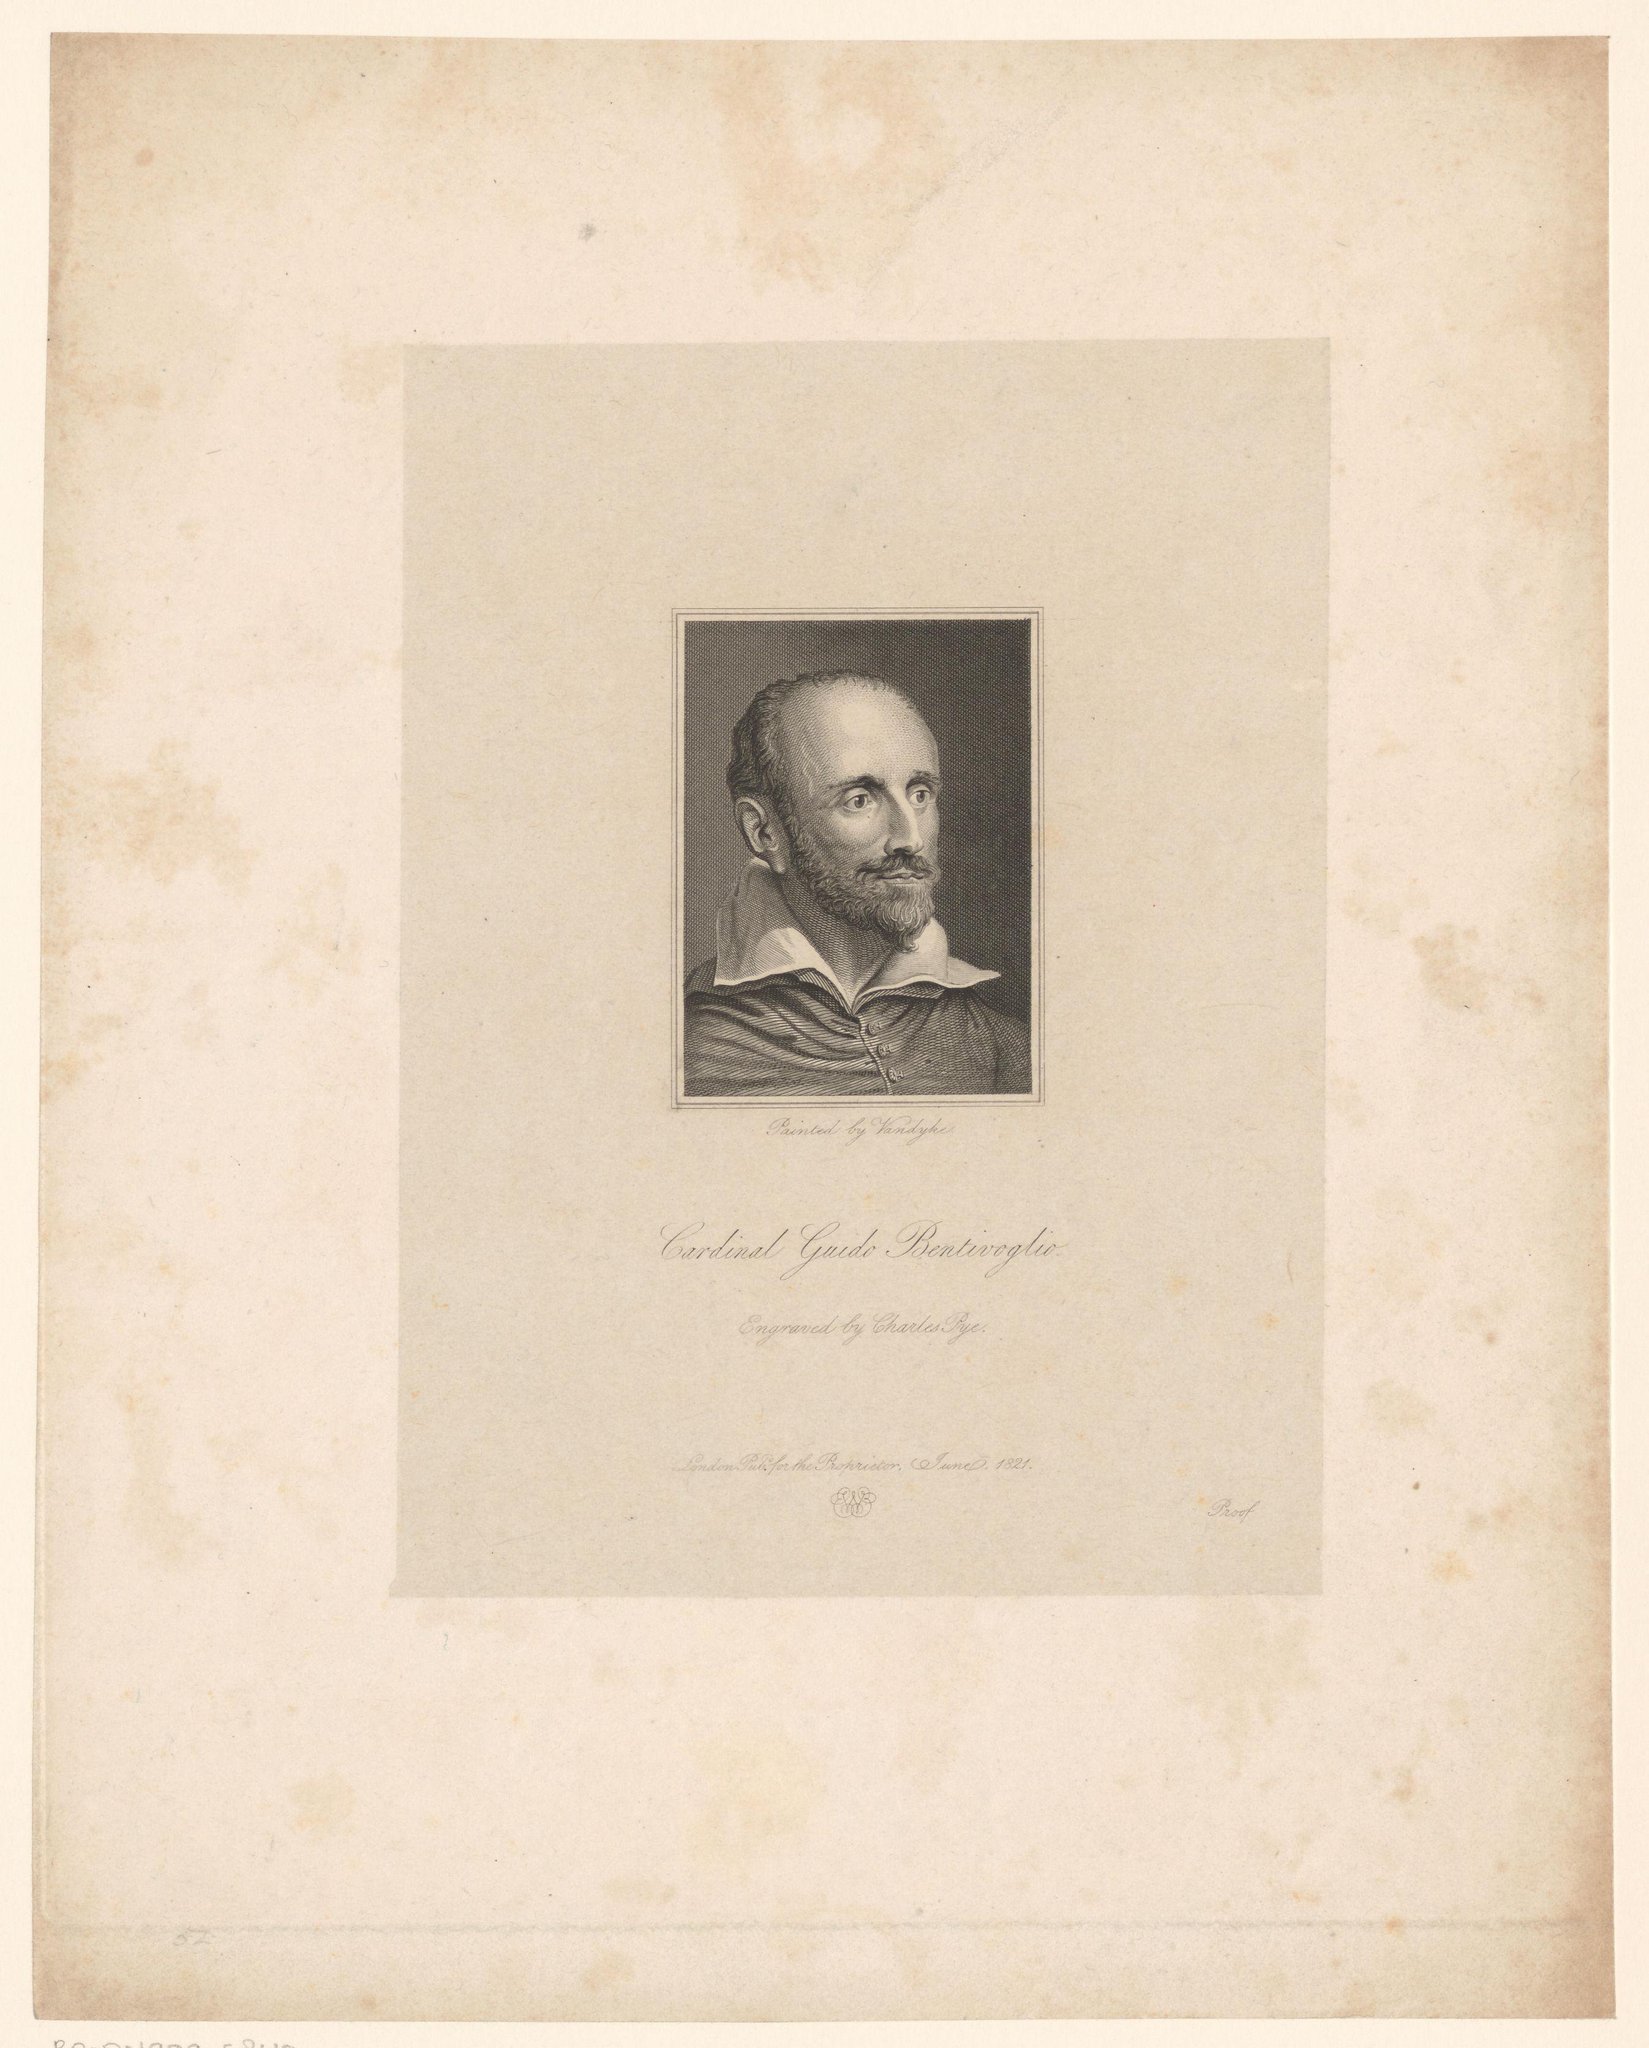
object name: print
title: Portret van Guido Bentivoglio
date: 1821-1822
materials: paper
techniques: engraving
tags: politician, theologian, historical persons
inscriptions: collector's mark: Lugt 2228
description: Prent gebruikt in: Walmsley, Edward. Physiognomical portraits. Londen: John Major, 1822.